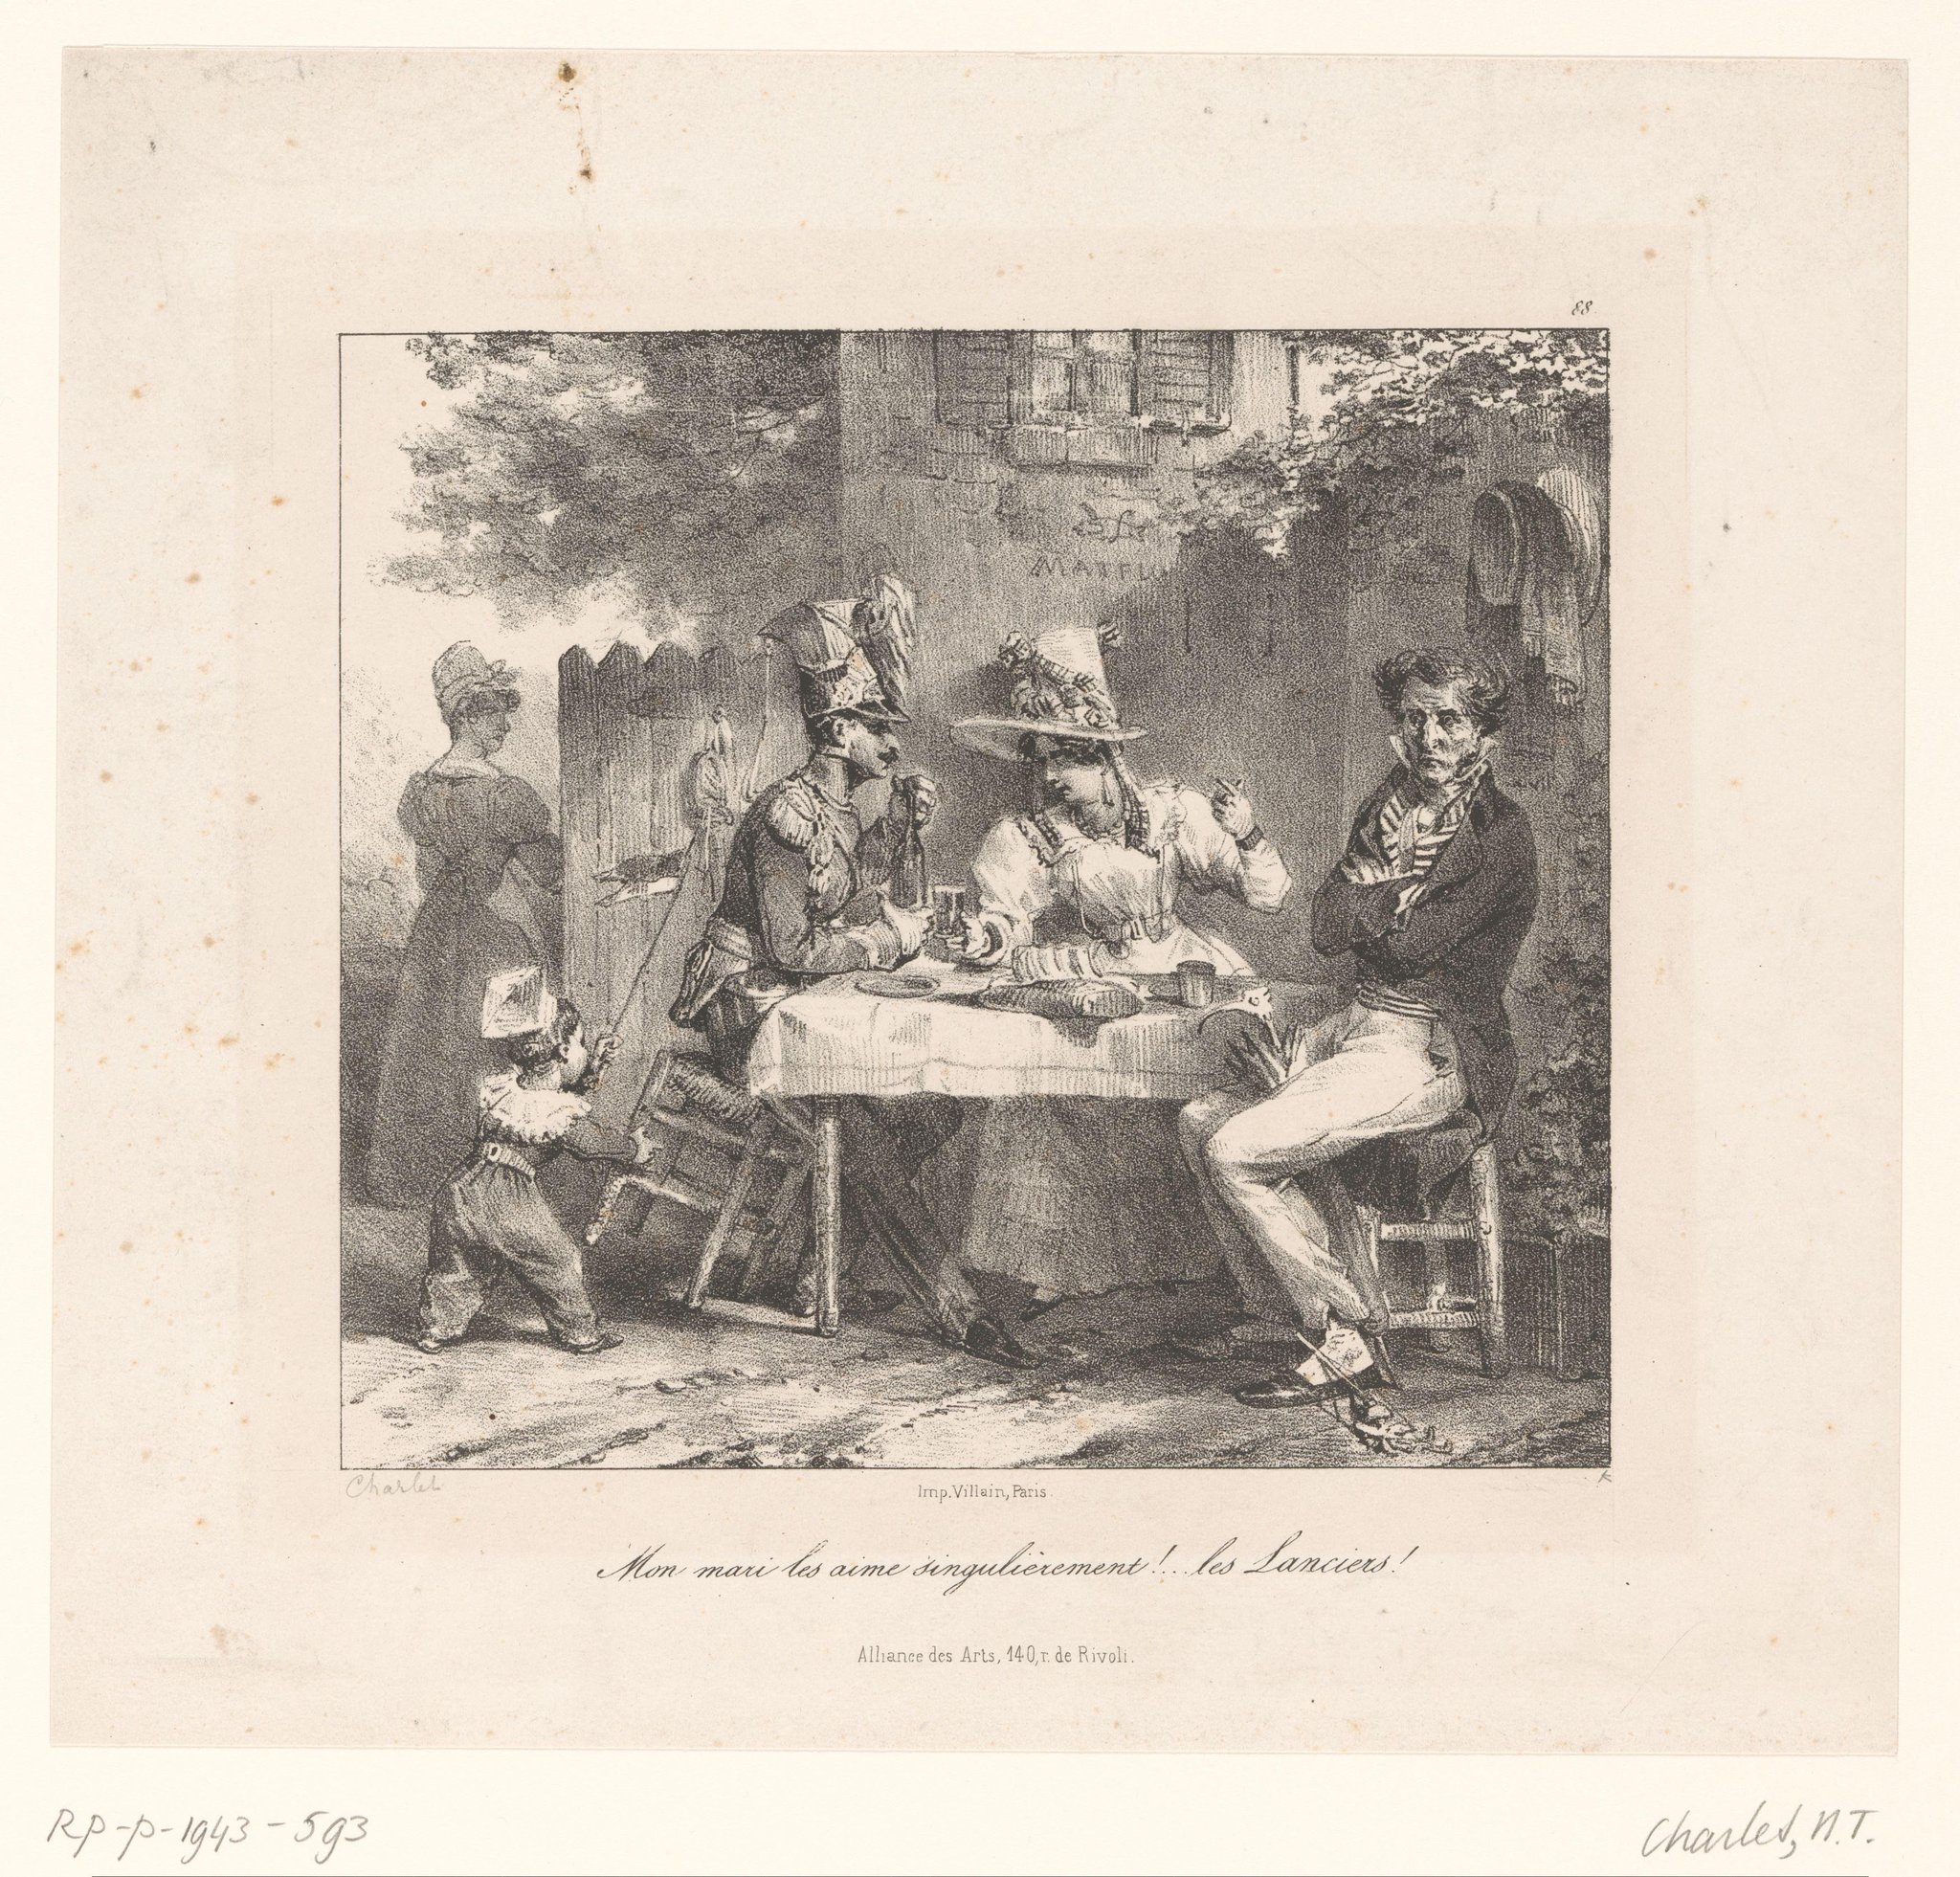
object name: cartoon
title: Album lithographique par Charlet 1827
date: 1842-1847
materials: paper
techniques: lithograph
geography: paris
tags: canteen ~ the soldier off duty, drinking, satire on marriage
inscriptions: collector's mark: Lugt 2228a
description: De vrouw verklaart het stuurse gedrag van haar man tegenover de lansier, die een glas wijn met haar wil drinken.